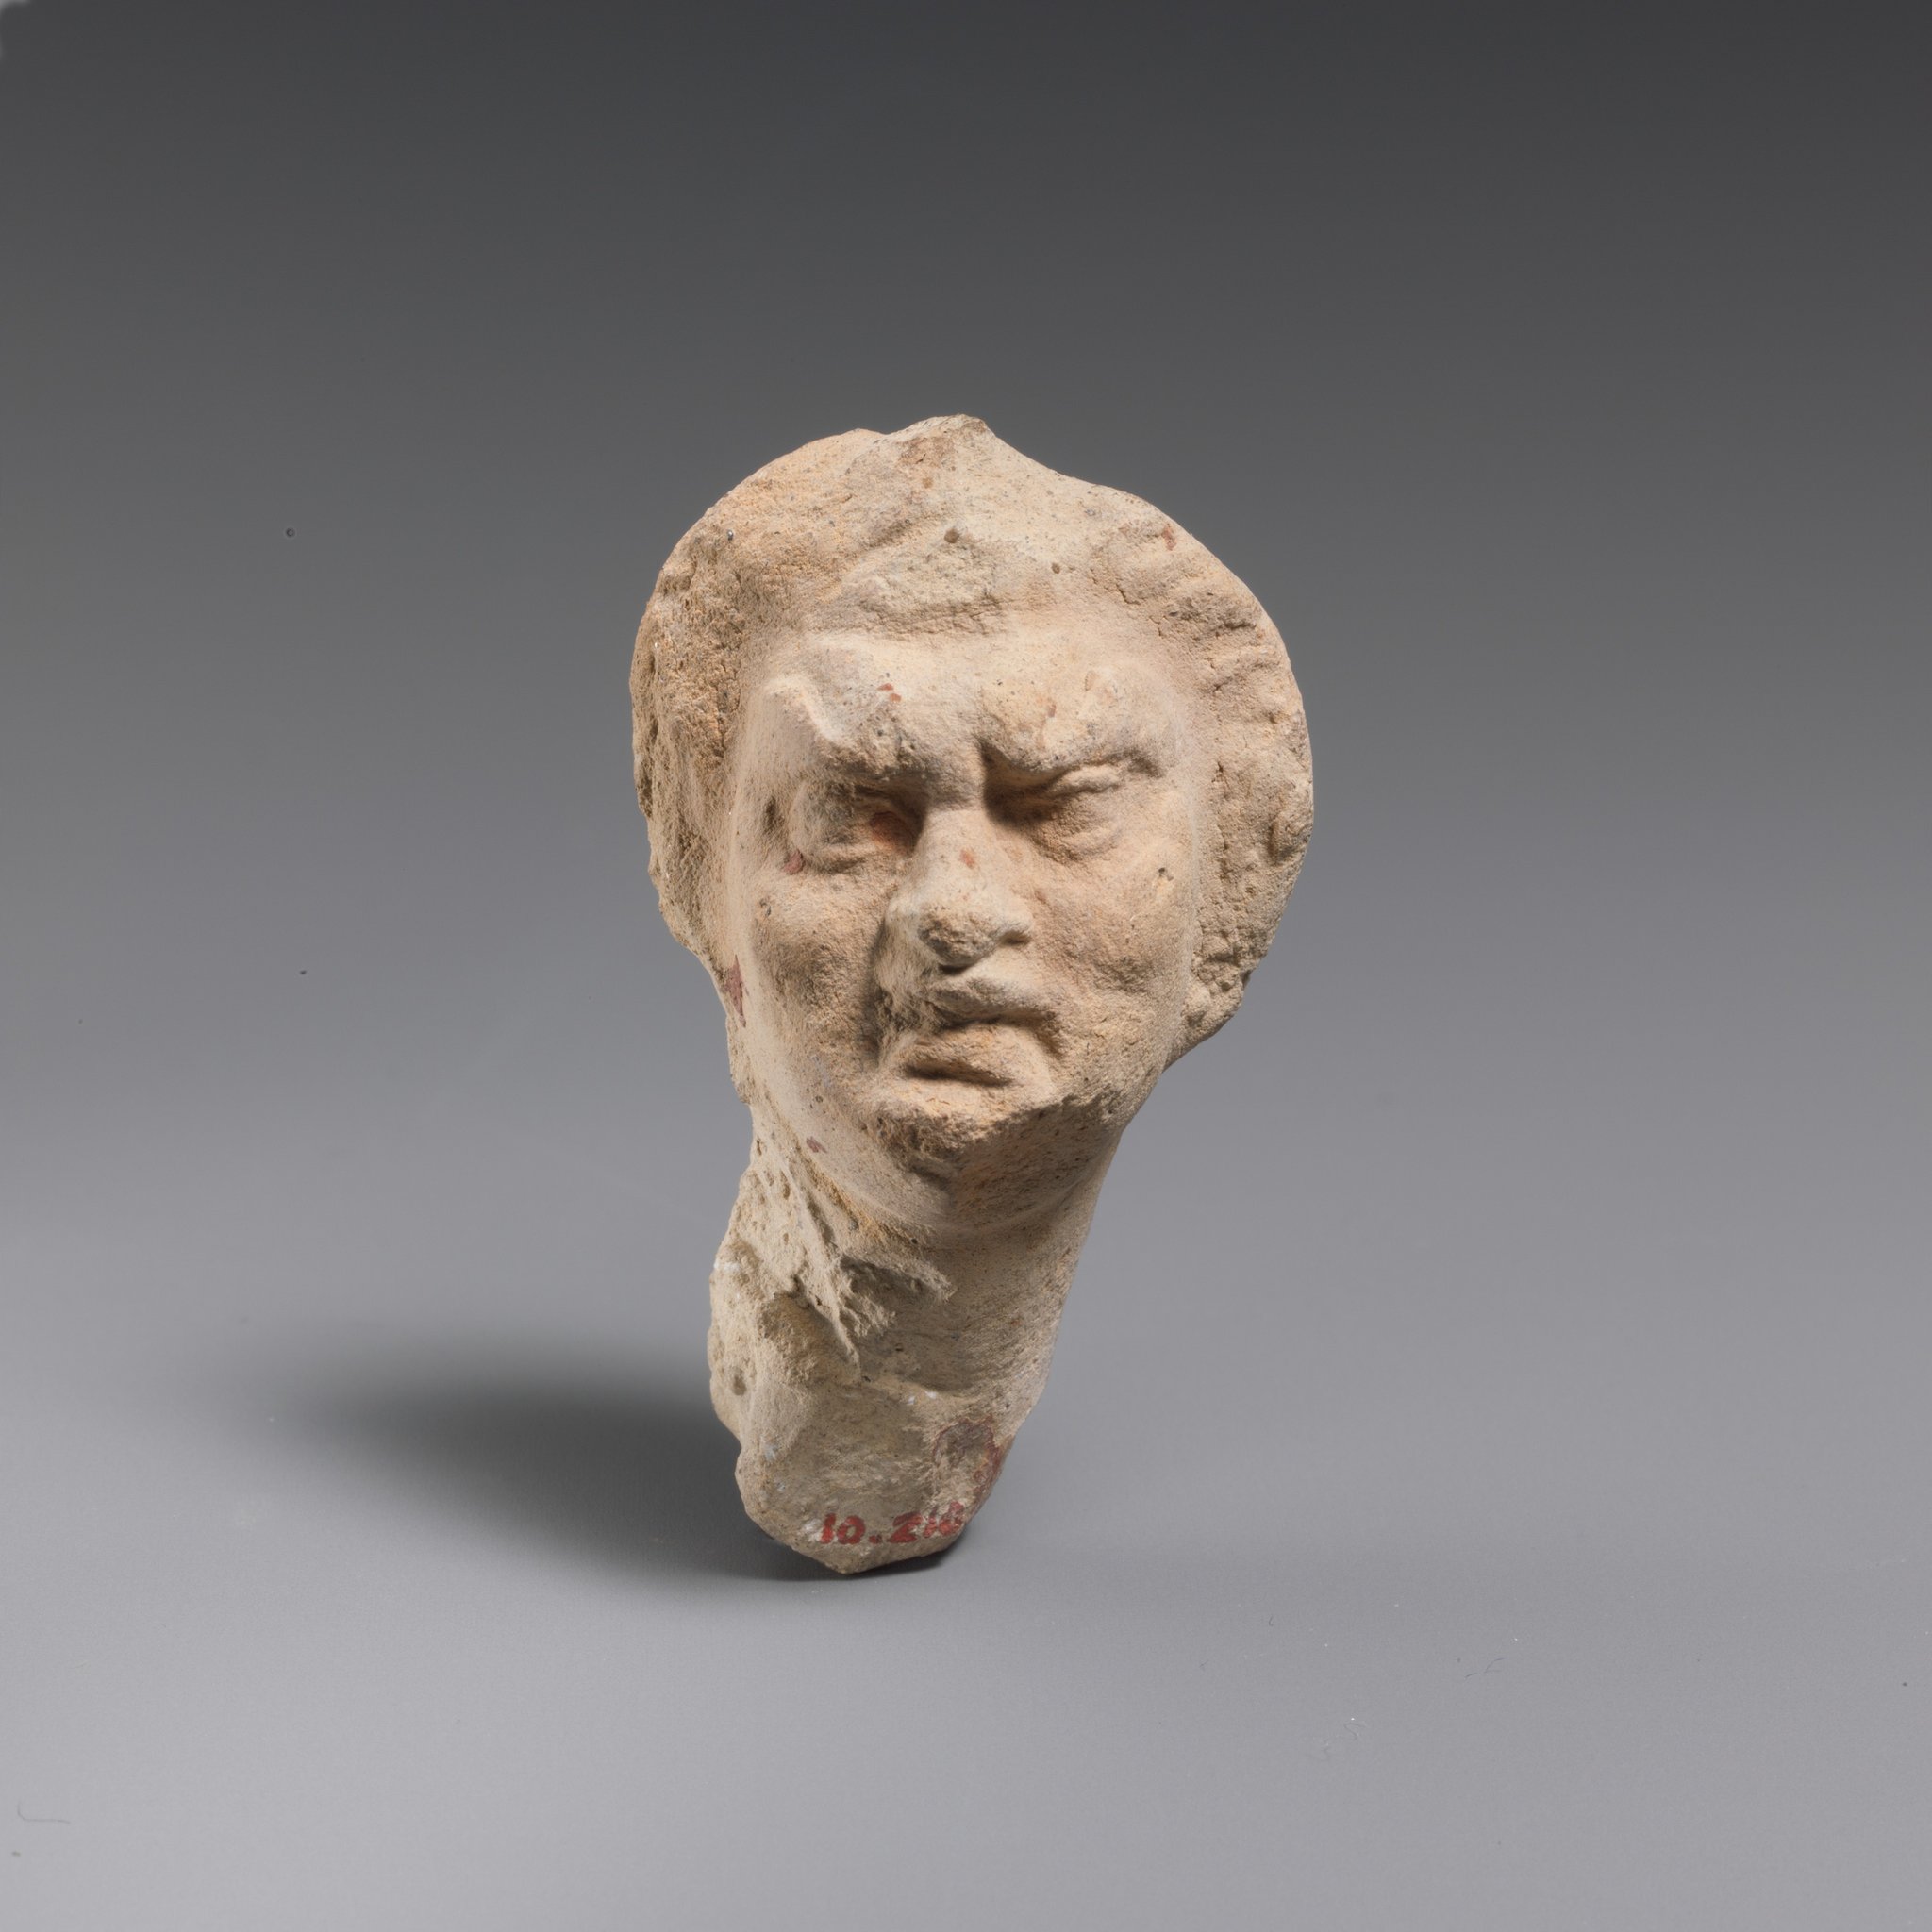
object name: head of an old woman, grotesque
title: Terracotta head of an old woman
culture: greek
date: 300-101 BCE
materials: terracotta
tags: heads,women